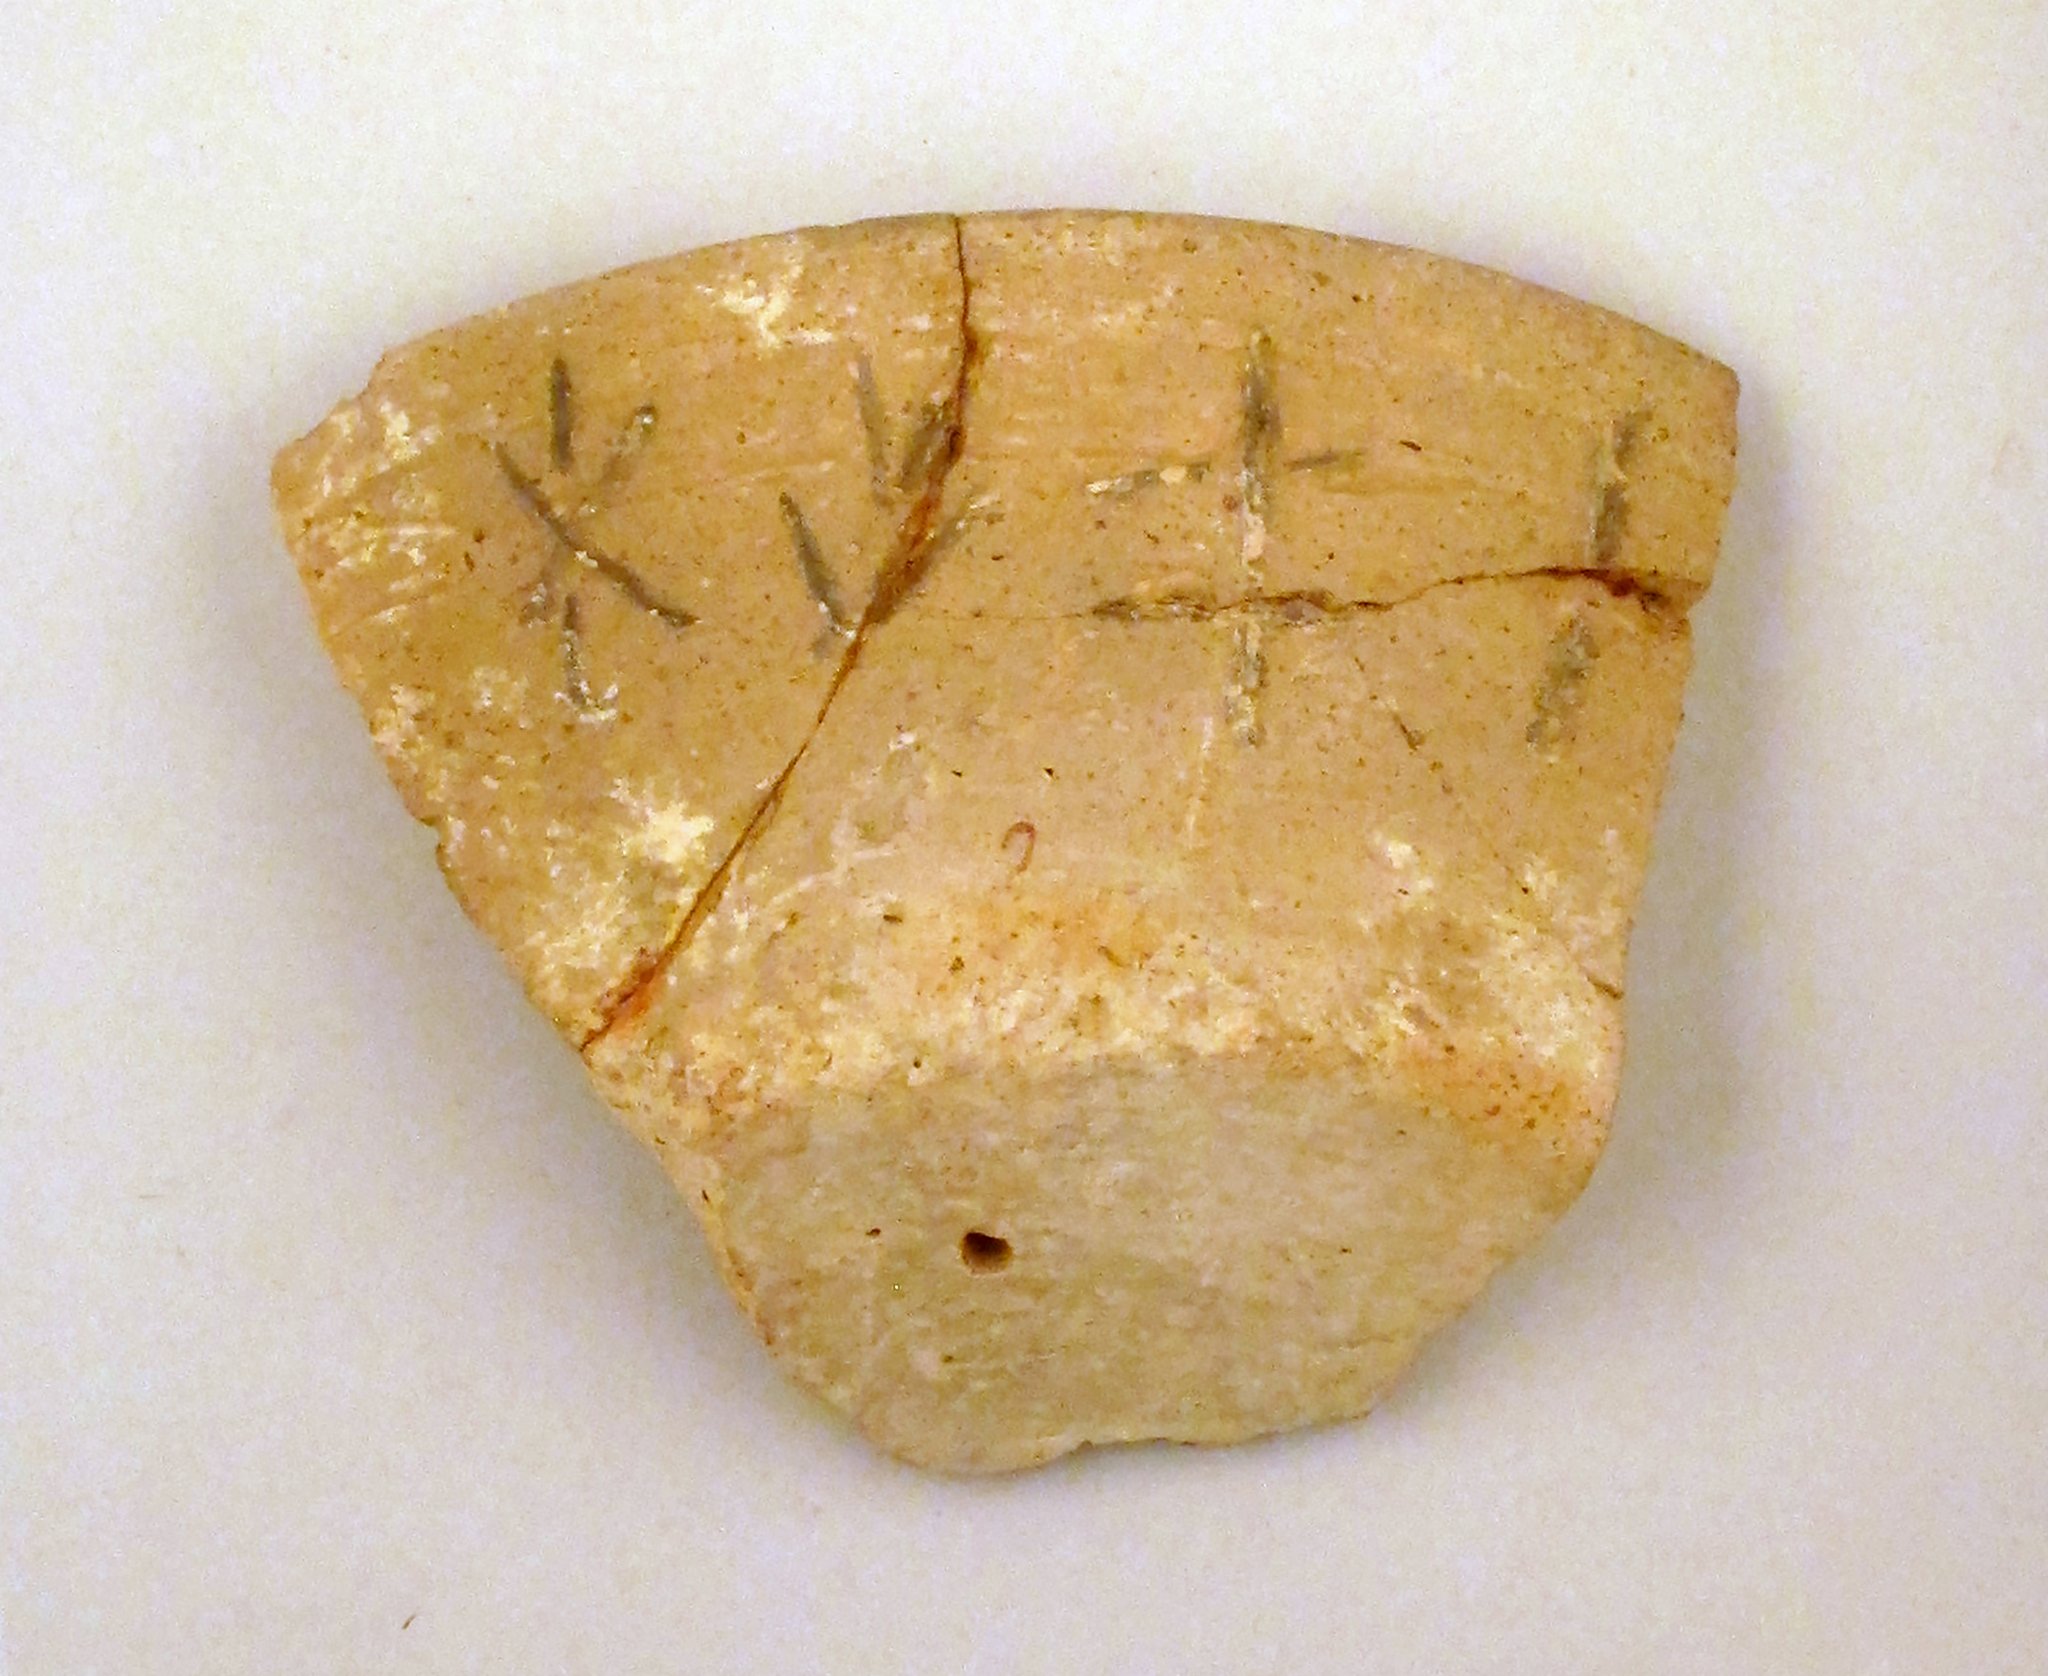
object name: box, inscribed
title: Limestone inscribed box fragment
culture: cypriot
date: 3900 BCE-100 CE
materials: stone